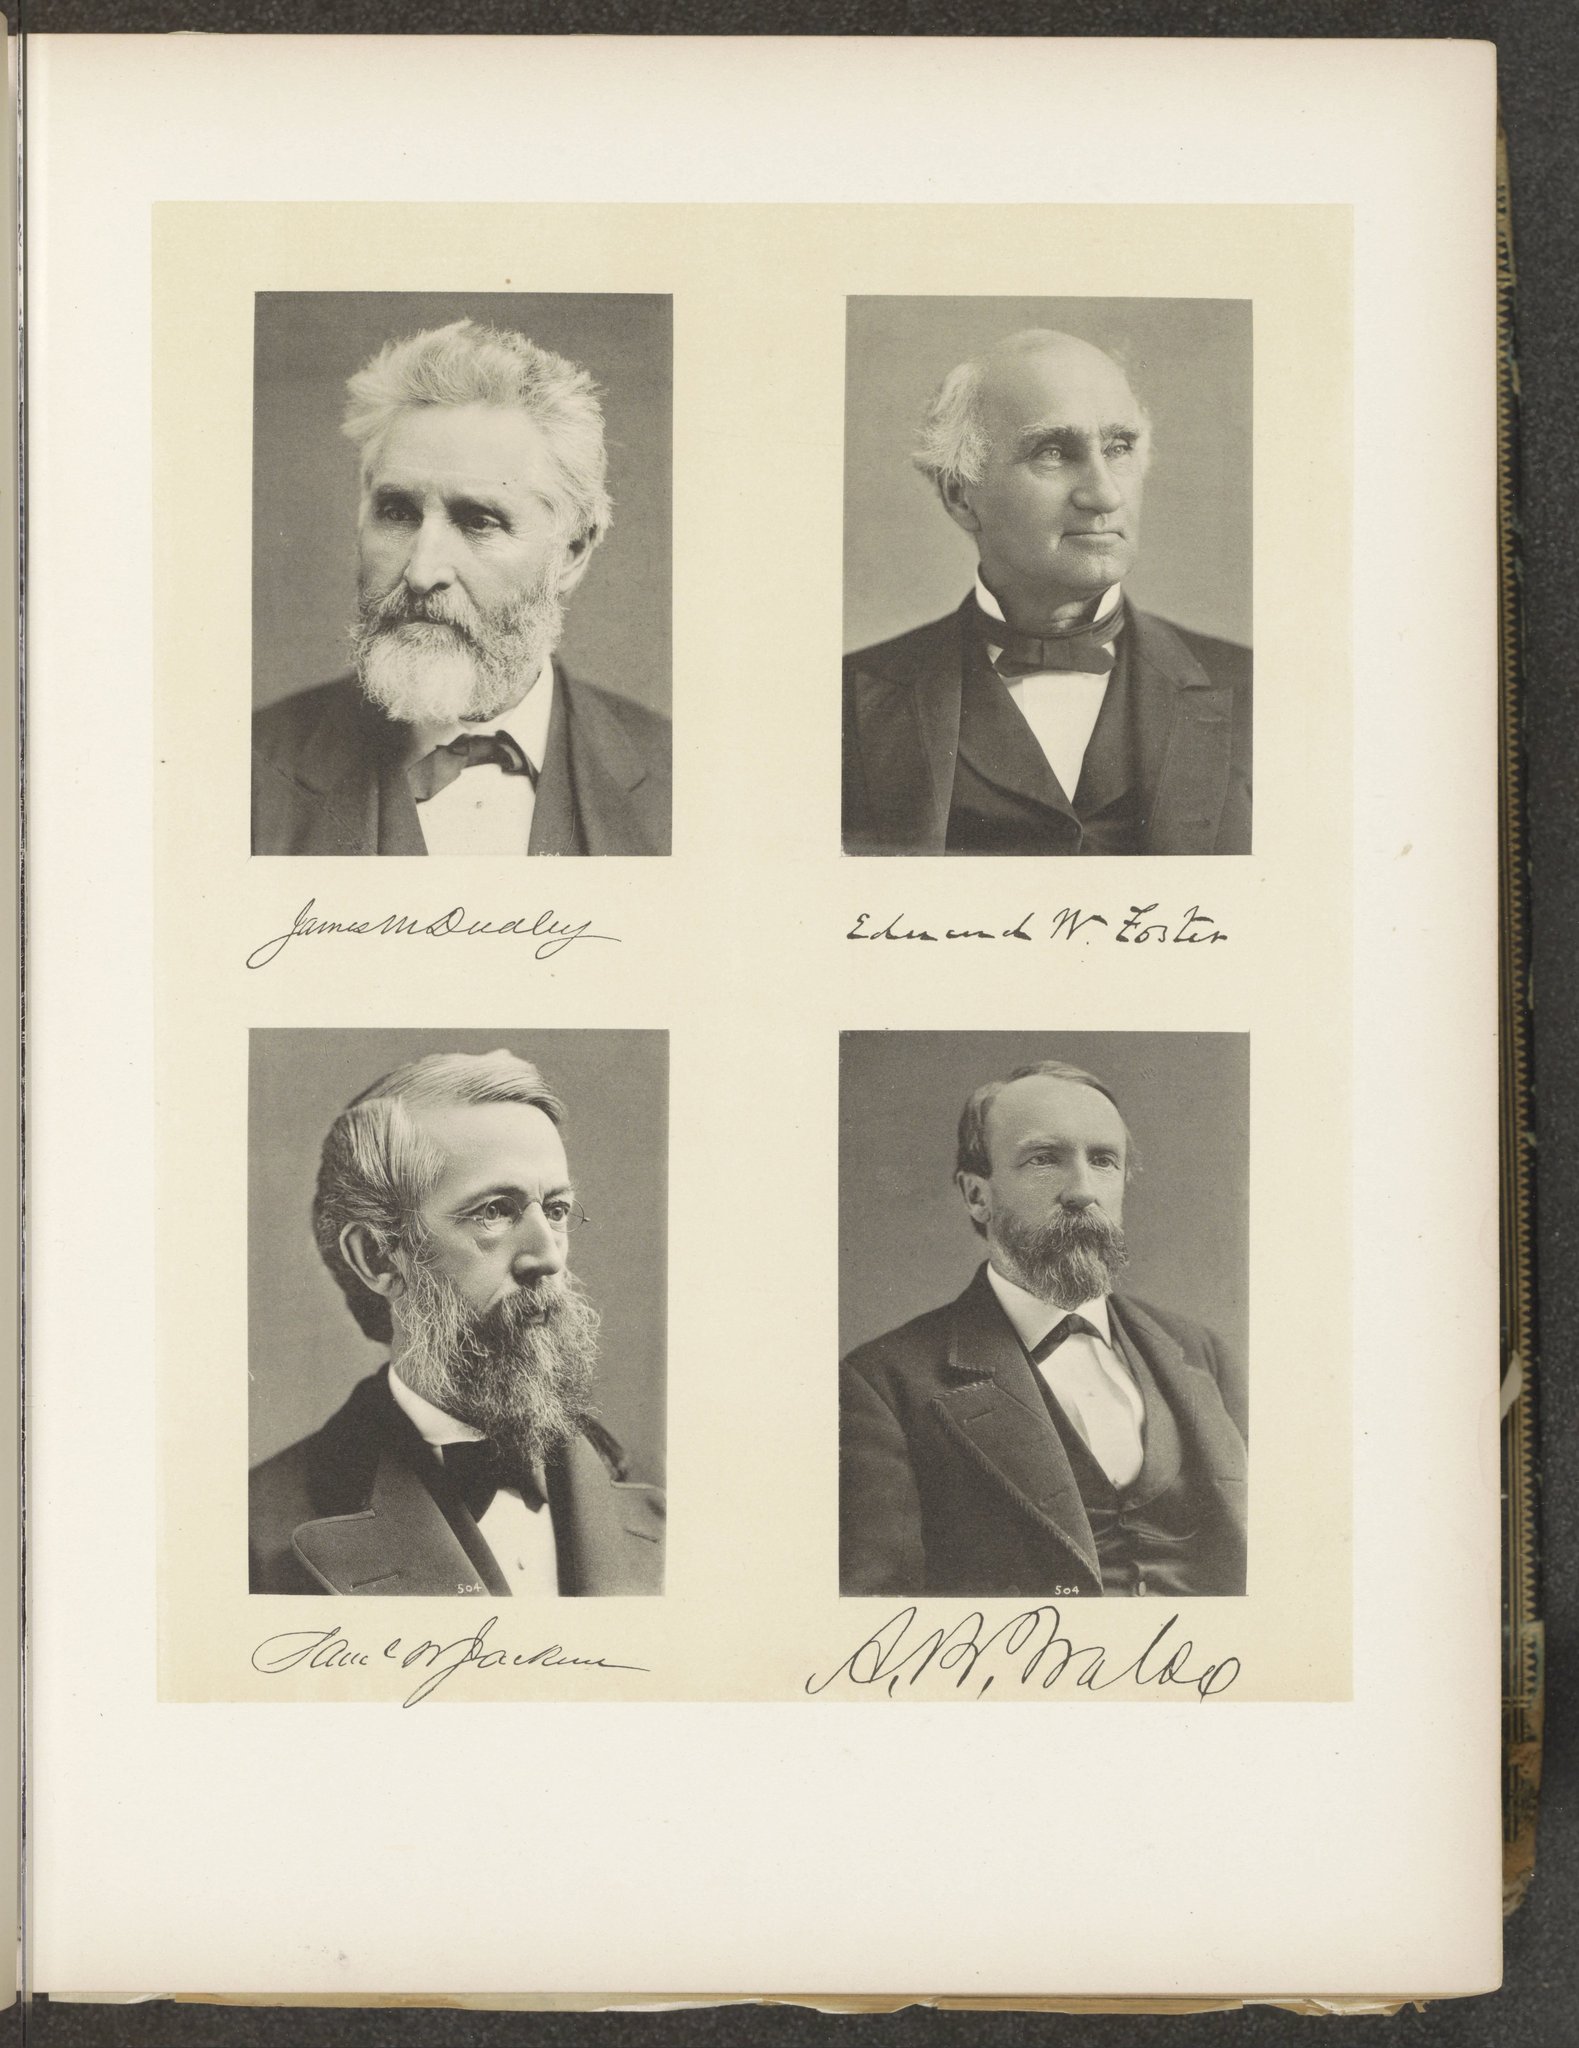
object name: page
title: Vier portretten van leden van de Constitutionele Commissie van de staat New York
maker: Anonymous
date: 1872-1882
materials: paper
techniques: photograph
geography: united states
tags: historical persons (+ head (and shoulders) (portrait))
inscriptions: annotation, number: ‘504’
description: Linksboven James M. Dudley, rechtsboven Edward W. Foster, linksonder Samuel W. Jackson, rechtsonder Artemas B. Waldo.